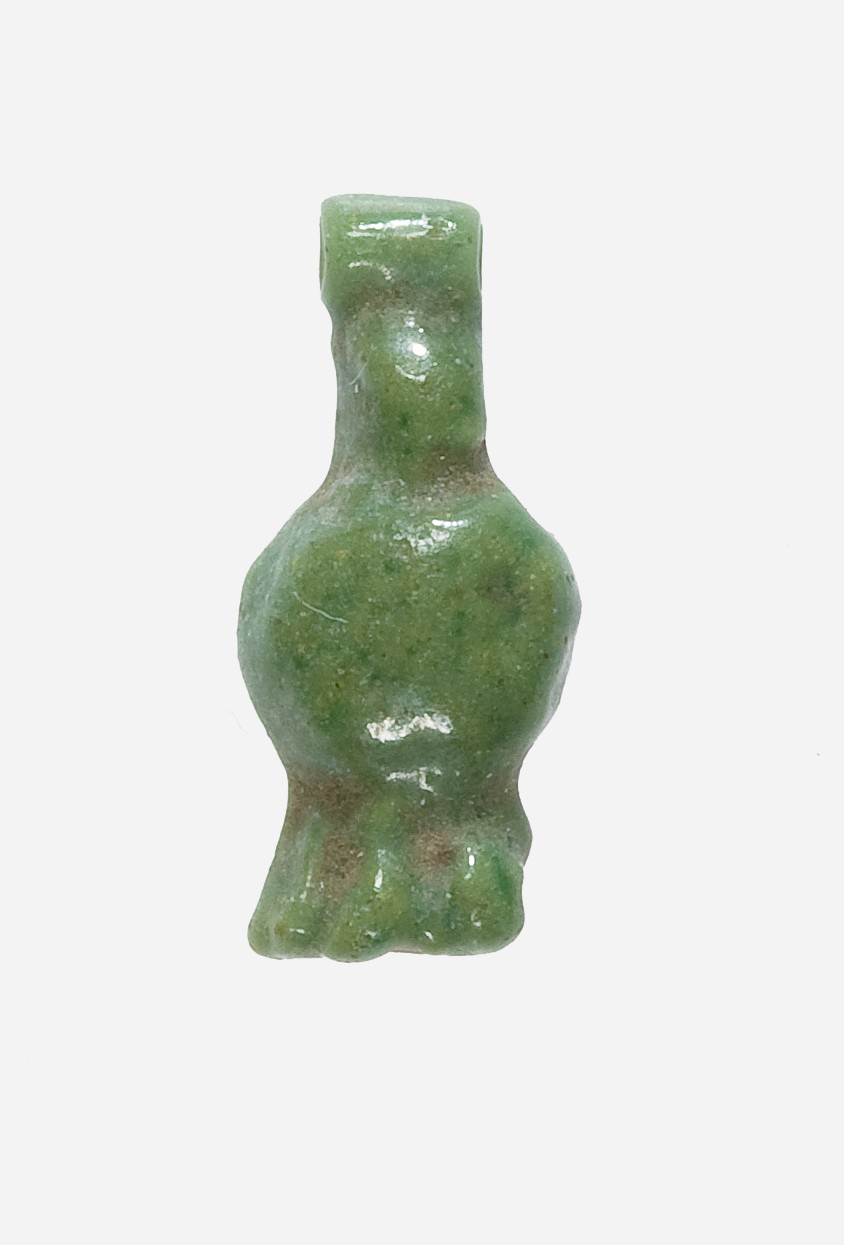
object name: pendant, cornflower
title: Cornflower Pendant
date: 1390-1352 BCE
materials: faience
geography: egypt